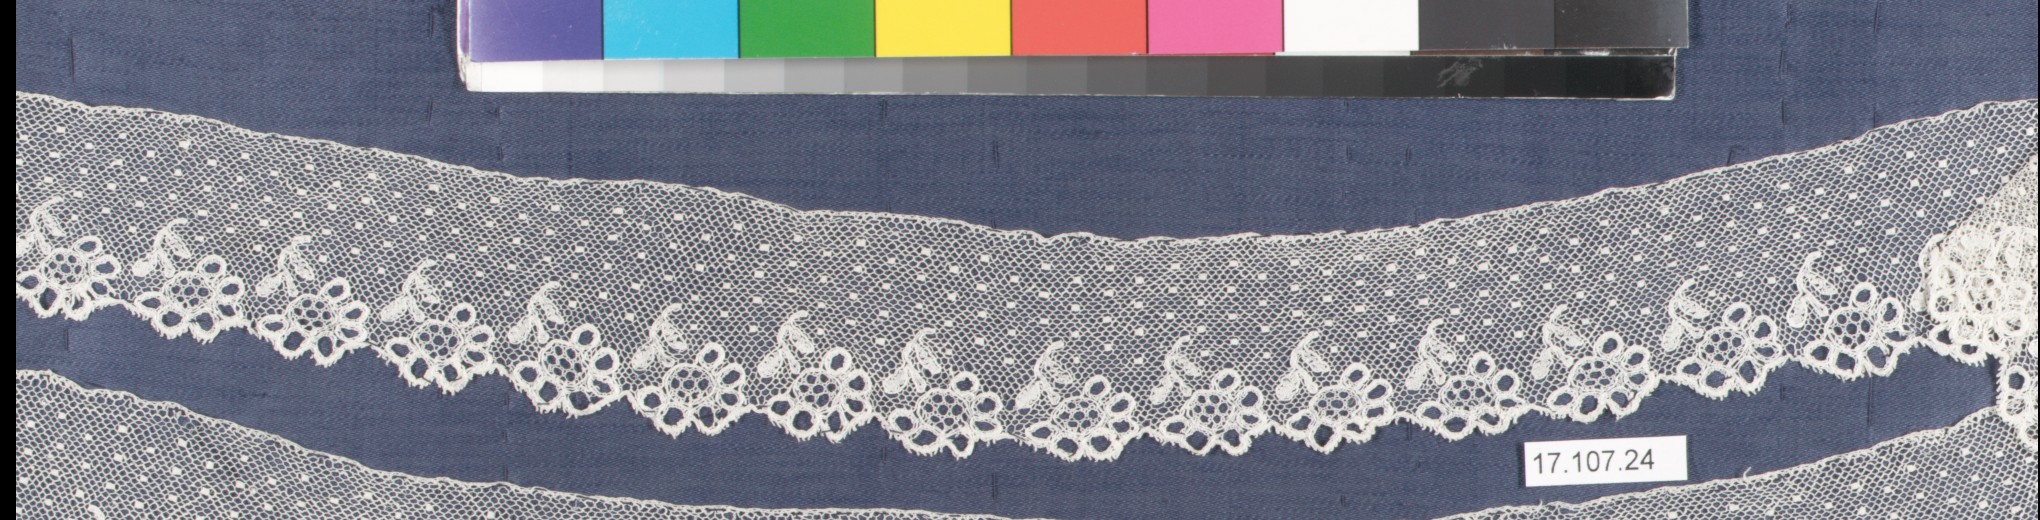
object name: piece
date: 1701-1900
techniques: lace